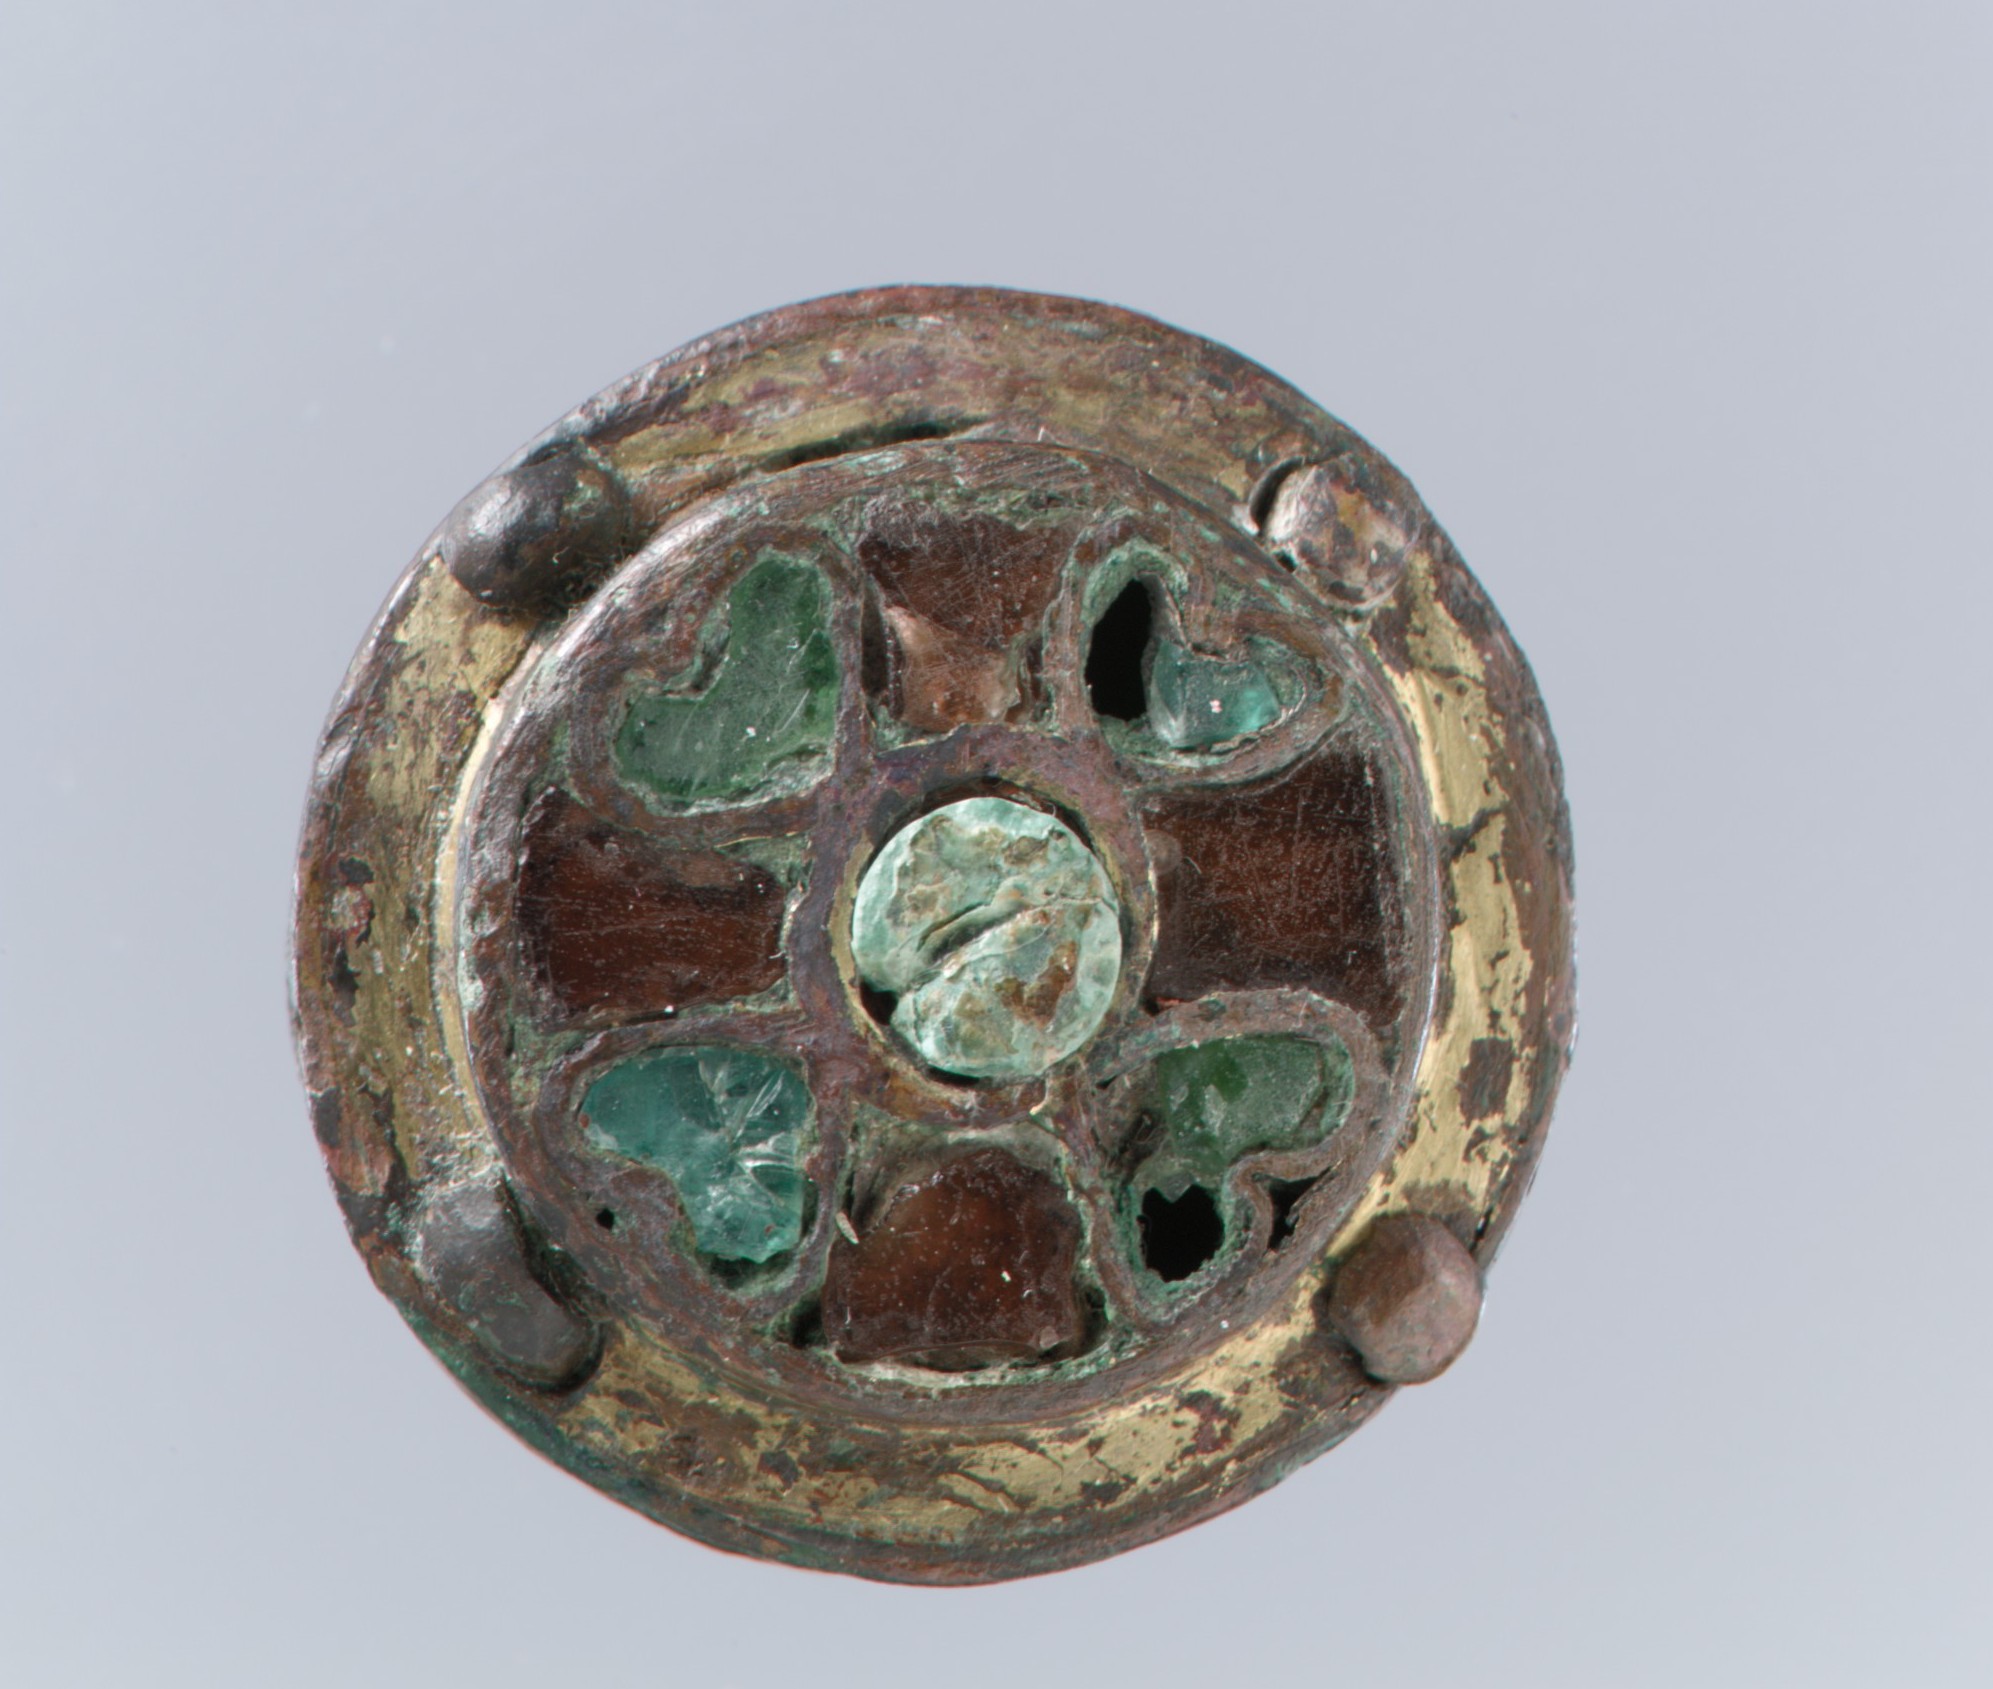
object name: brooch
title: Disk Brooch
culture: frankish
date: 501-600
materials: copper alloy, foil, garnet, glass, silver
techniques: gilding, inlay